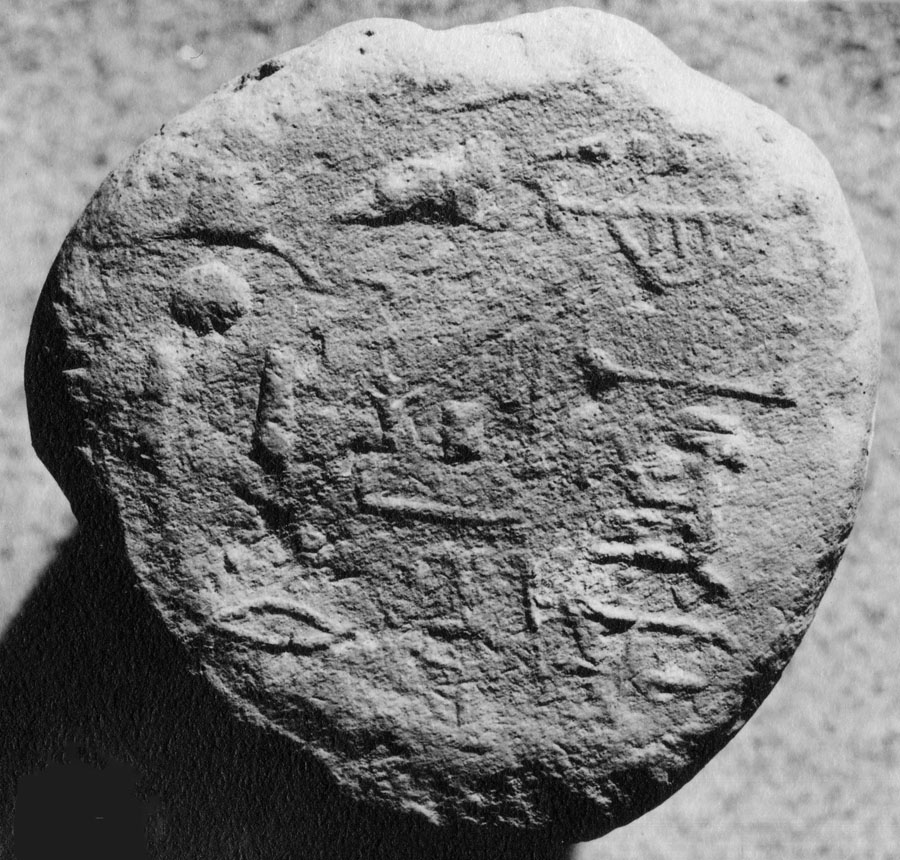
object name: cone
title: Funerary Cone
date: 1550-1295 BCE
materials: pottery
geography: egypt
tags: hieroglyphs